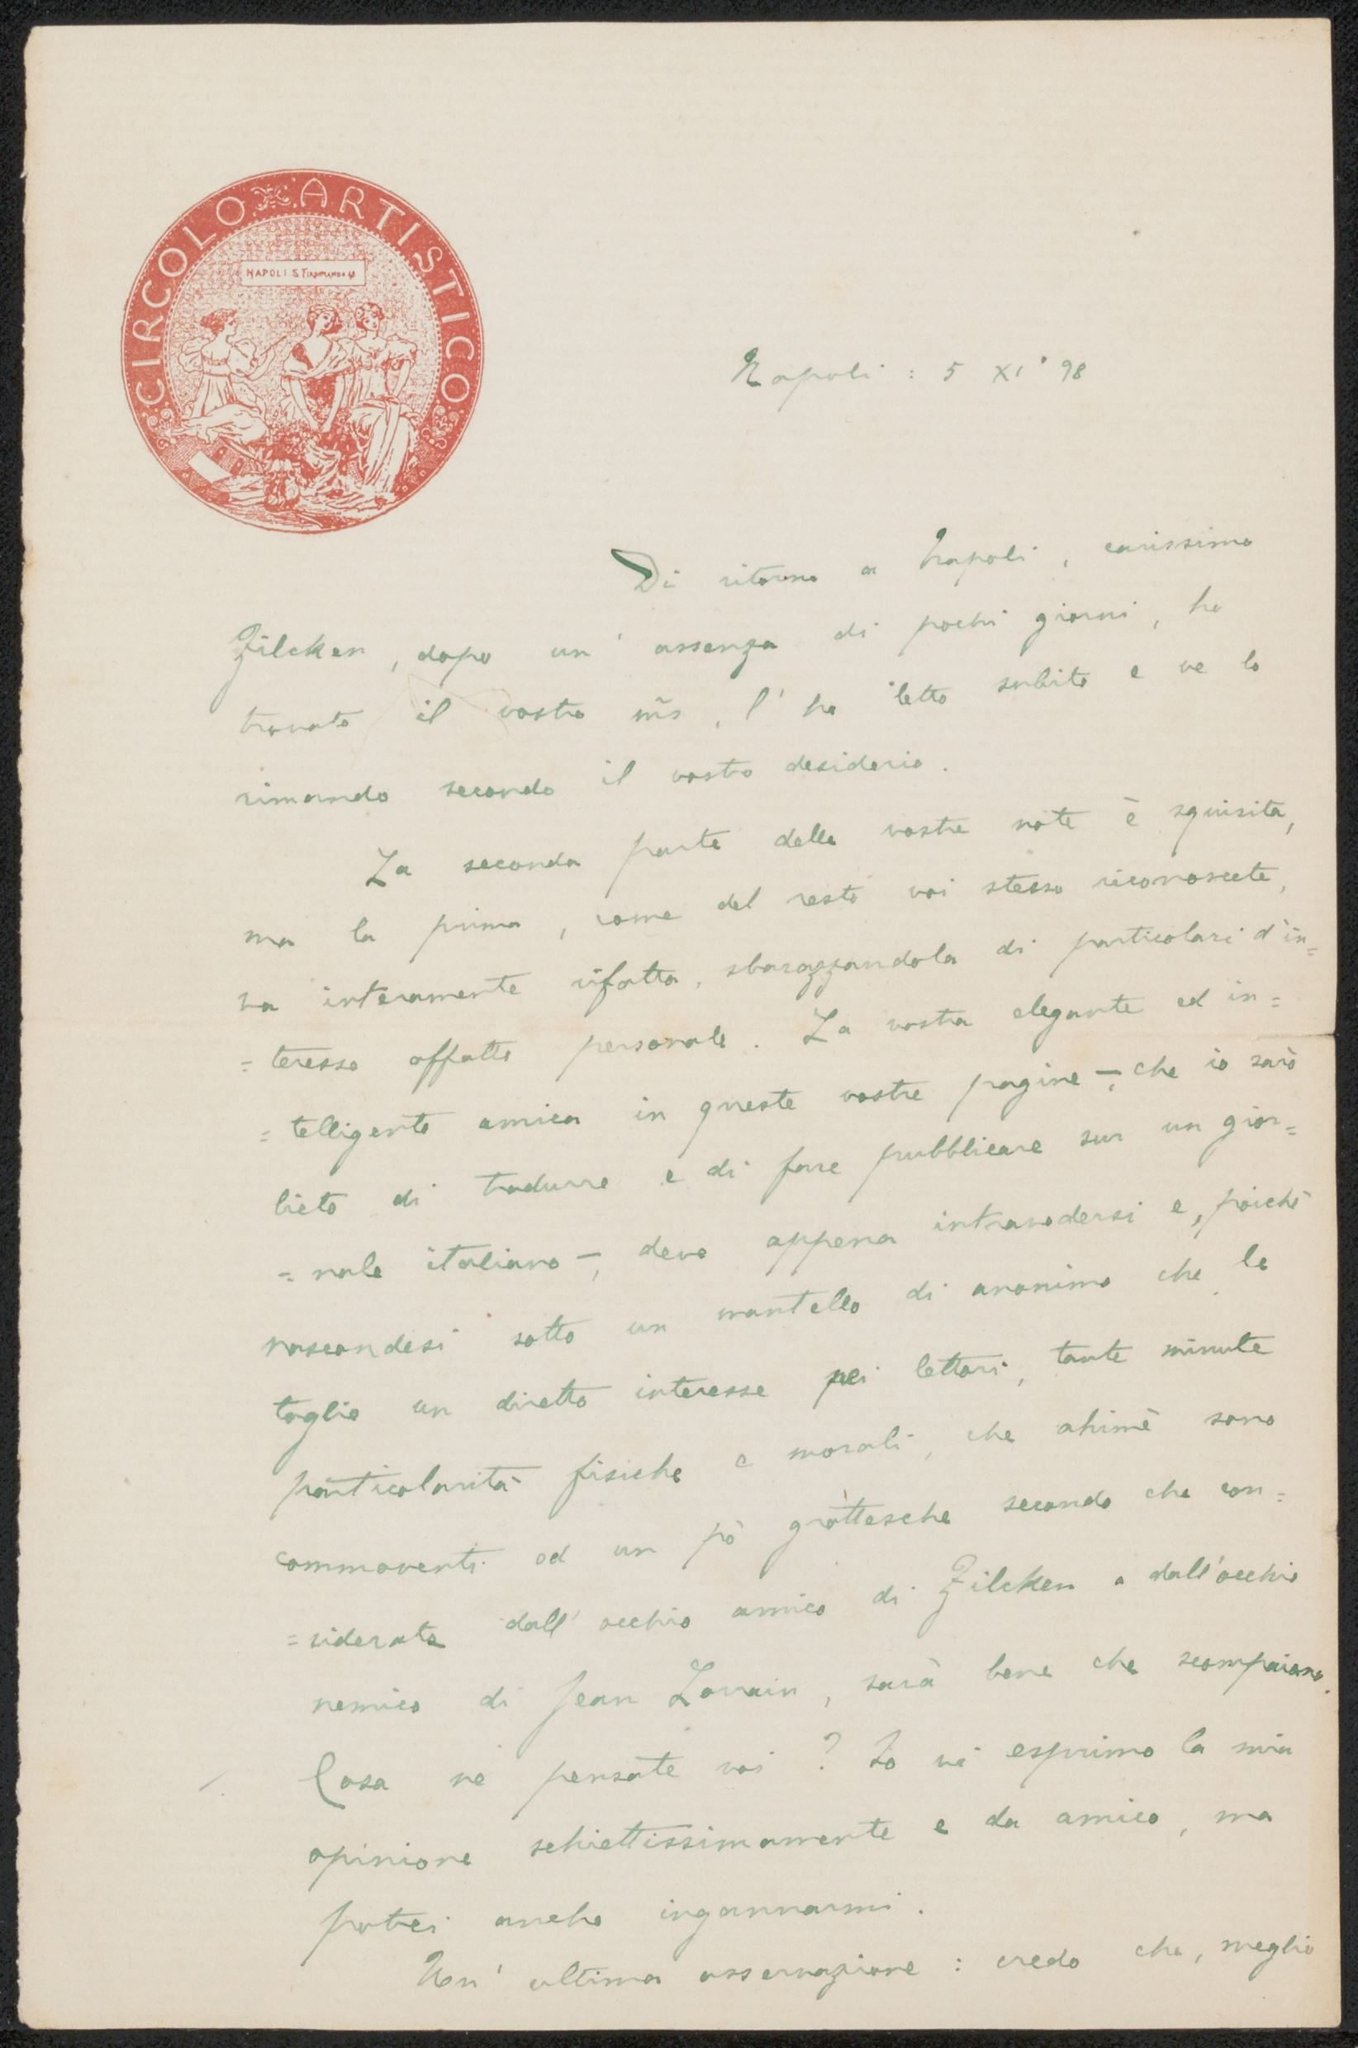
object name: letter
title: Brief aan Philip Zilcken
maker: vittorio pica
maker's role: criticus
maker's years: 1864-1930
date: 1898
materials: ink, paper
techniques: pen, printing, writing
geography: naples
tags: painter, philip zilcken, printed matter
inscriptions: collector's mark: ‘RPK’